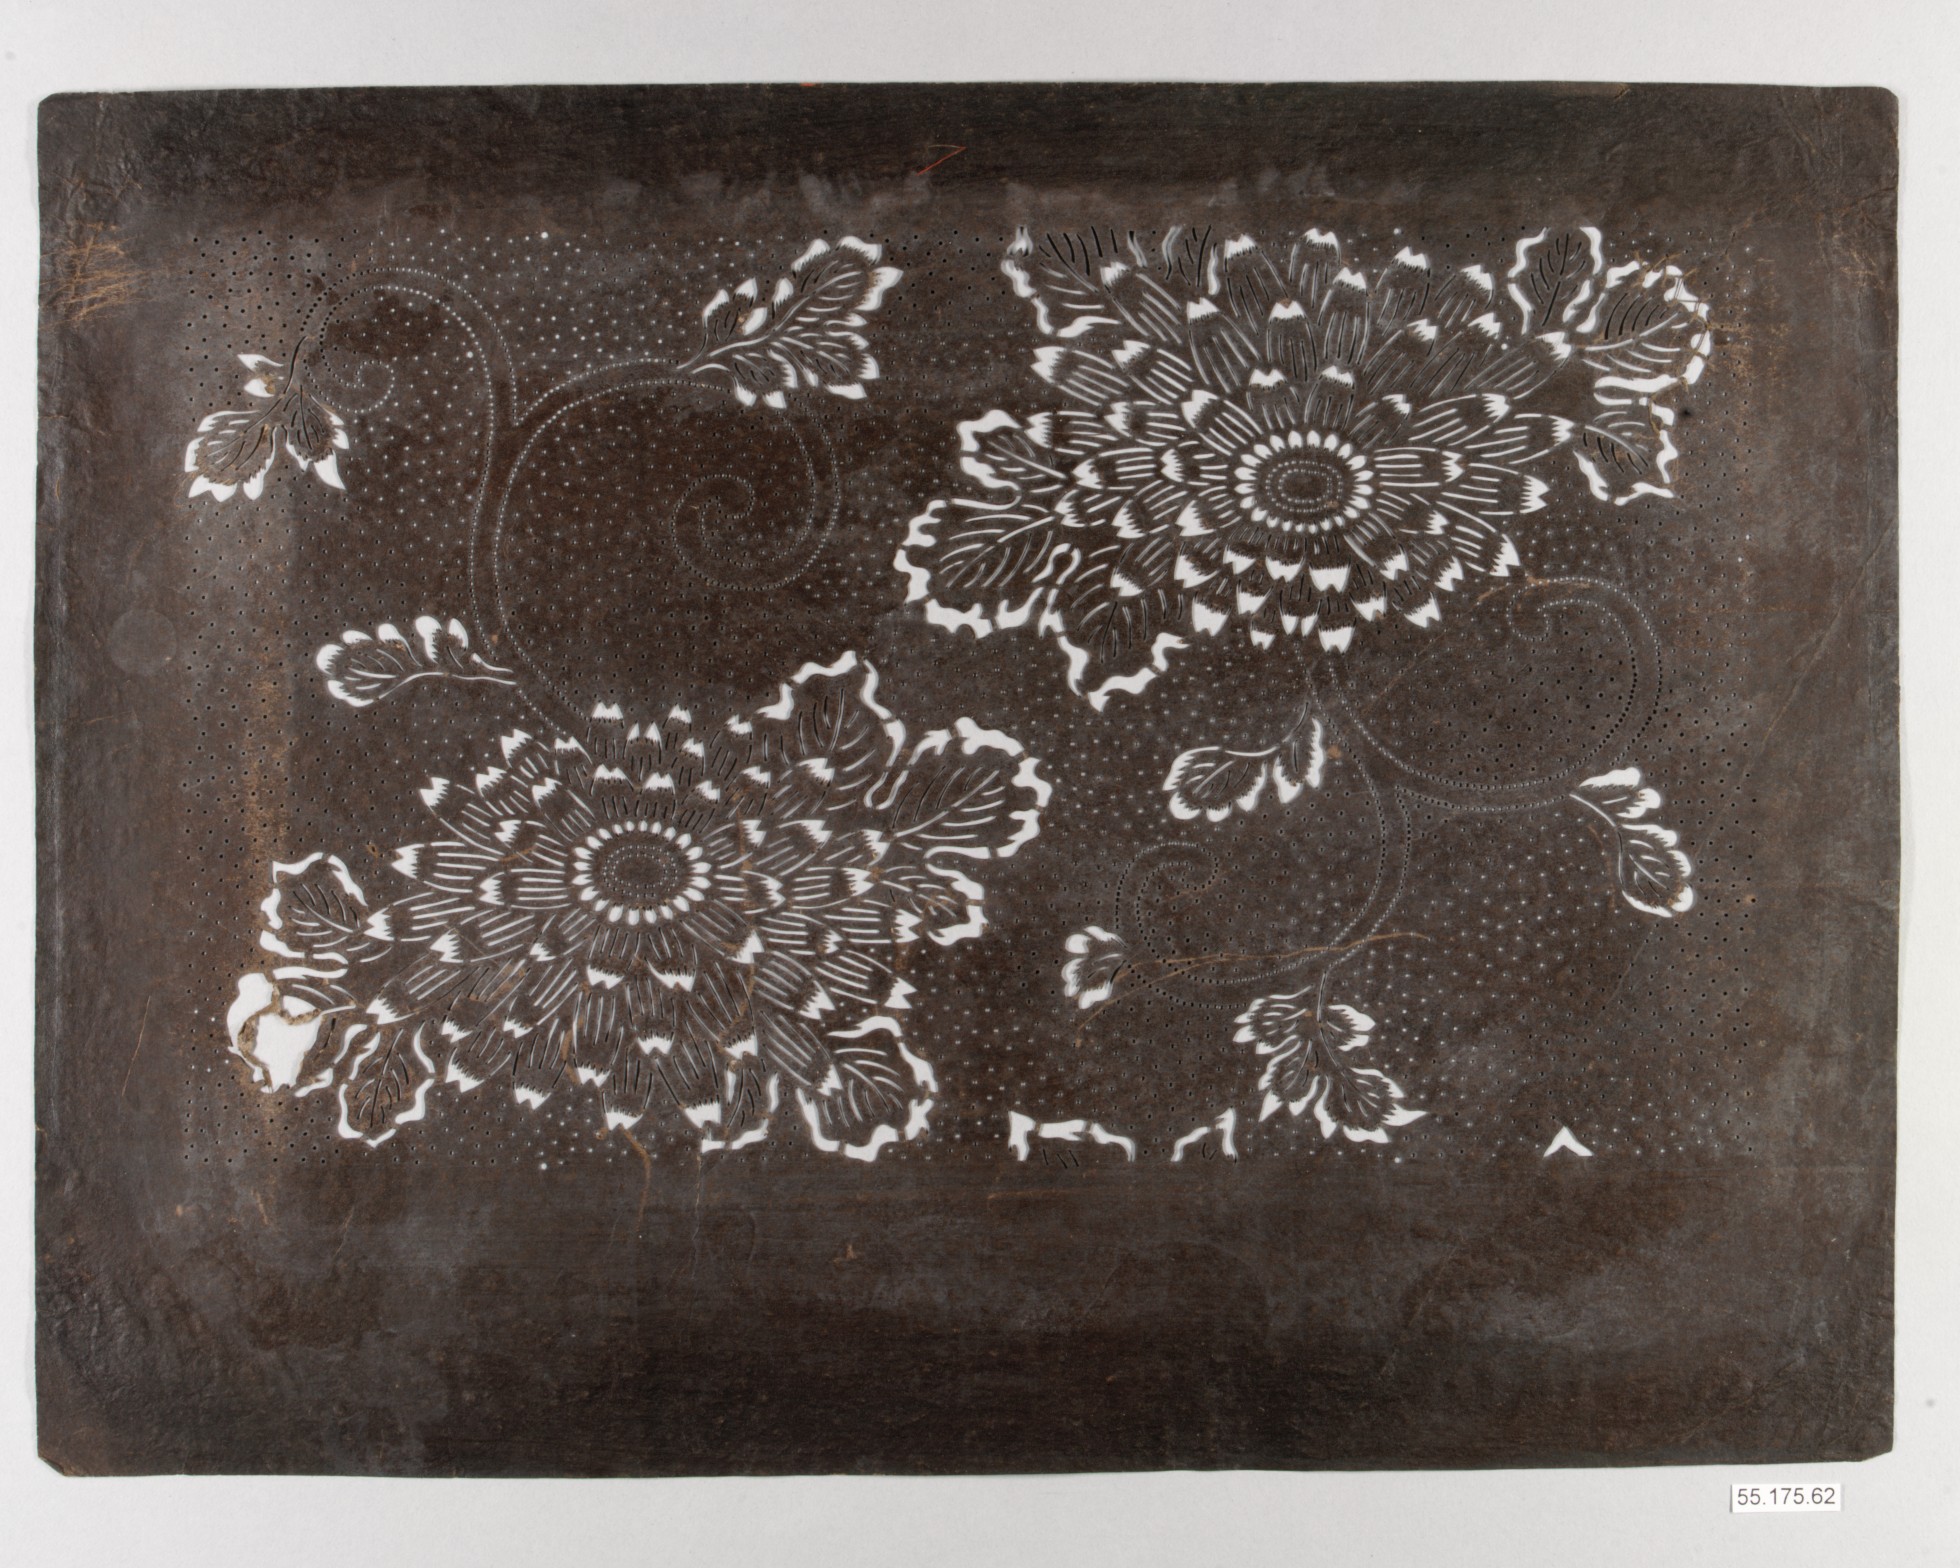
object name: stencil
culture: japanese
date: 1801-1900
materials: paper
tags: flowers